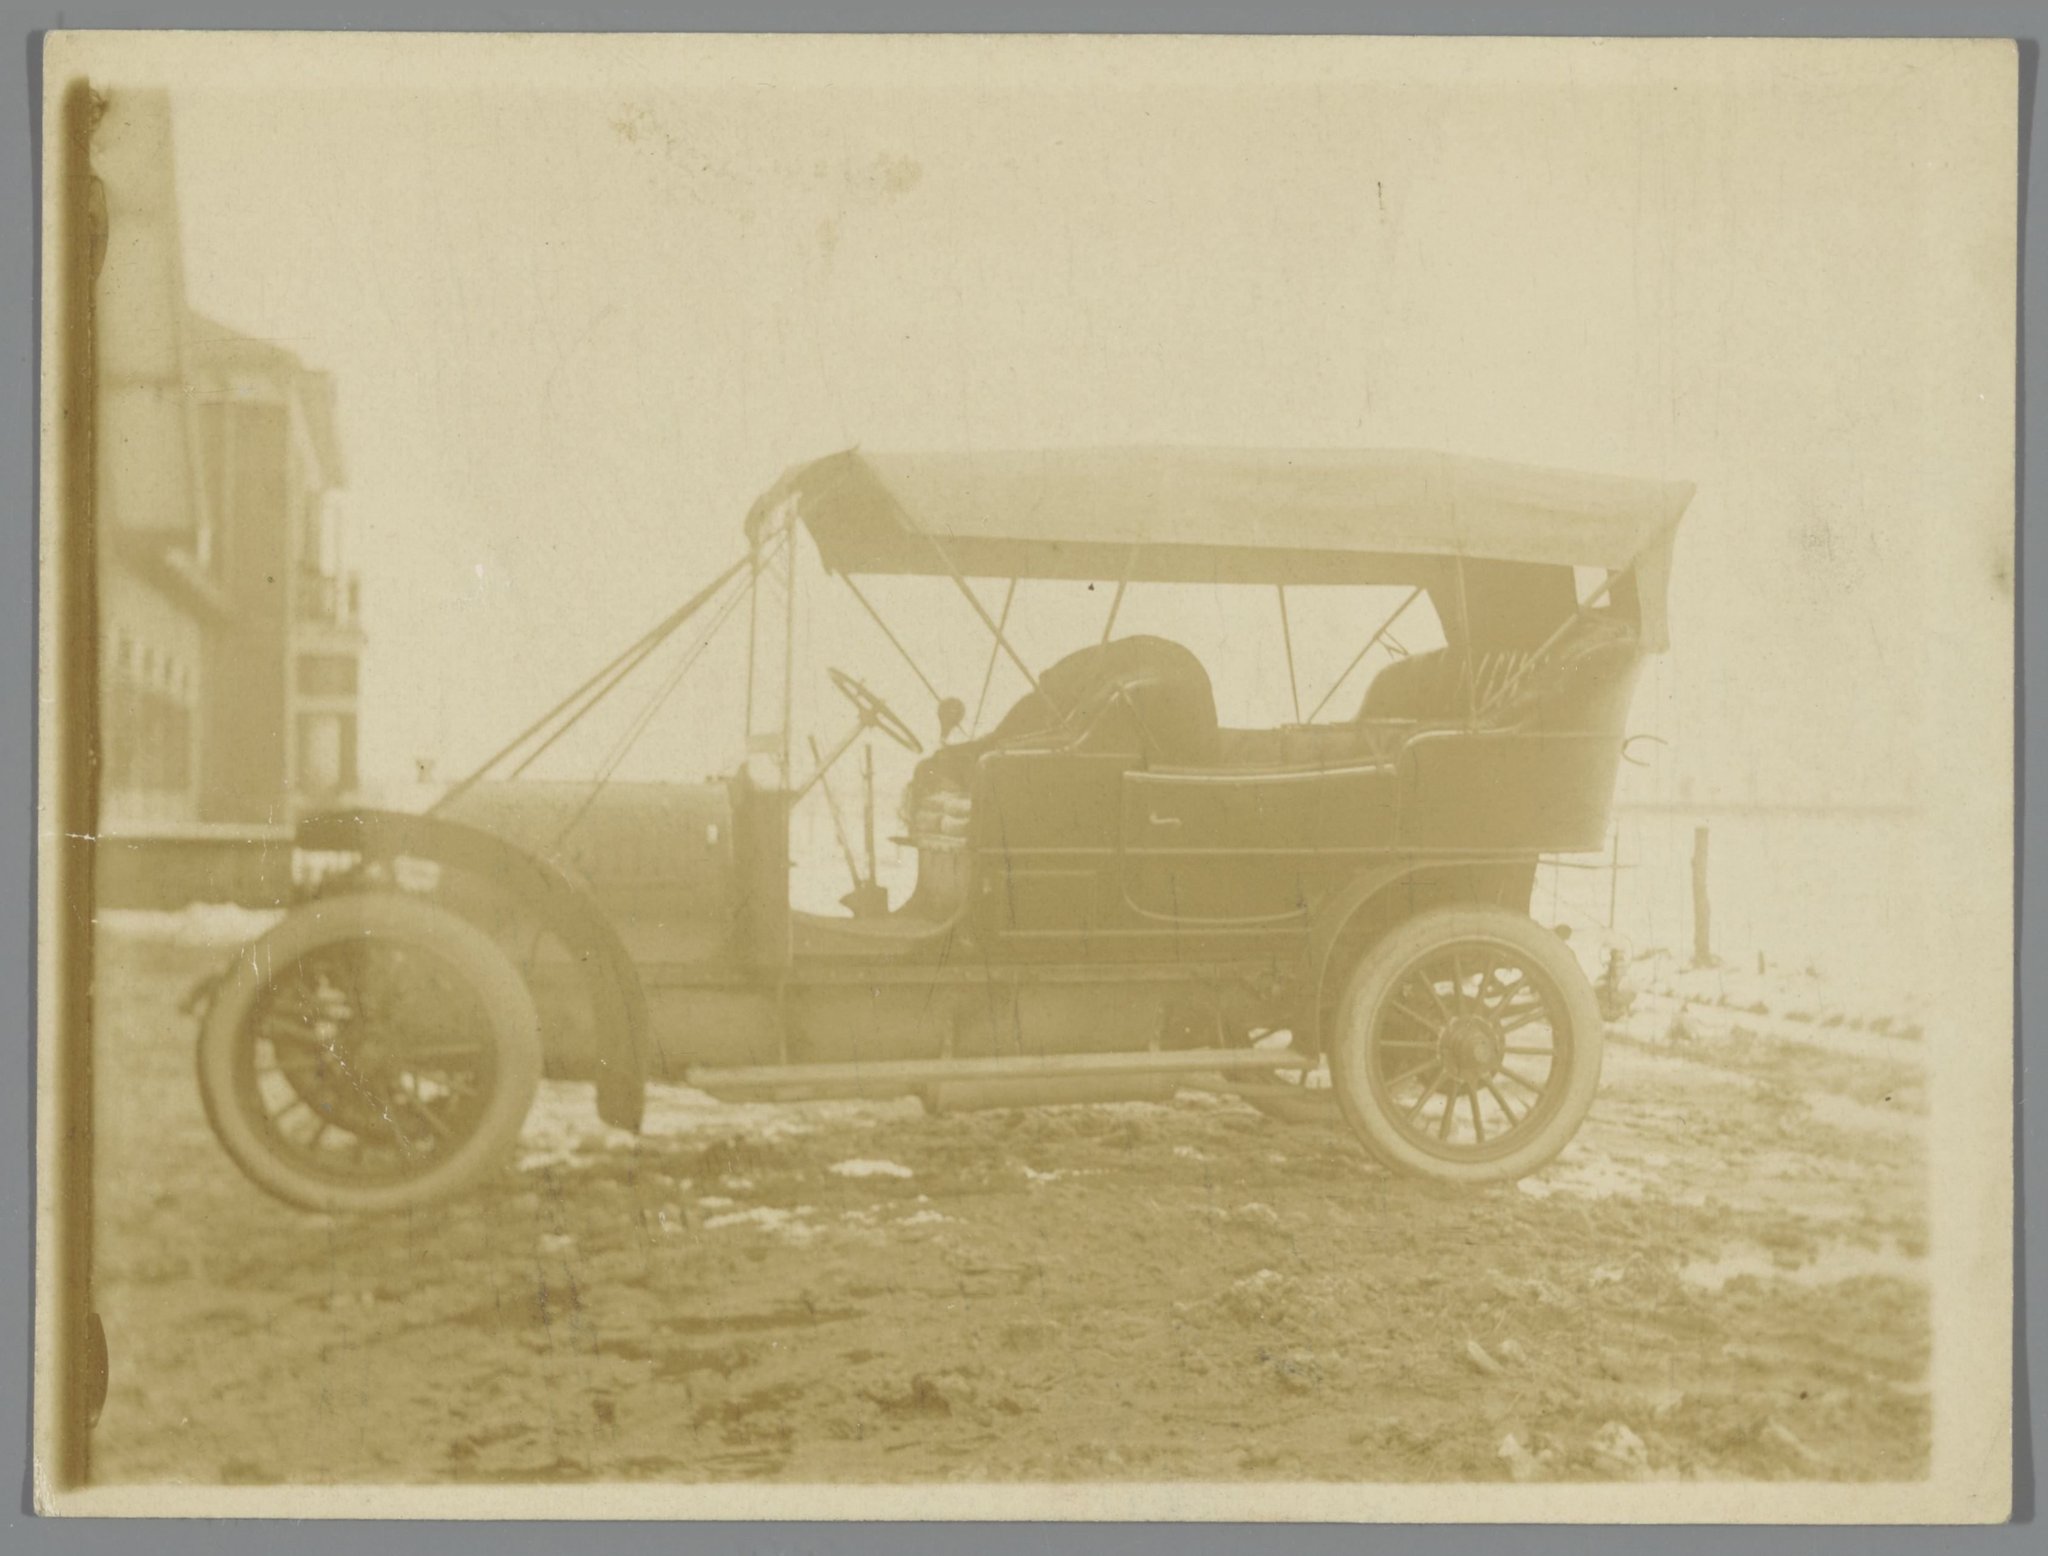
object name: photograph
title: Automobiel op een strand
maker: dirk van der mark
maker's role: amateurfotograaf, handelaar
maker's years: 1877-1934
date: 1910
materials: paper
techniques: gelatin silver print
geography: netherlands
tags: automobile